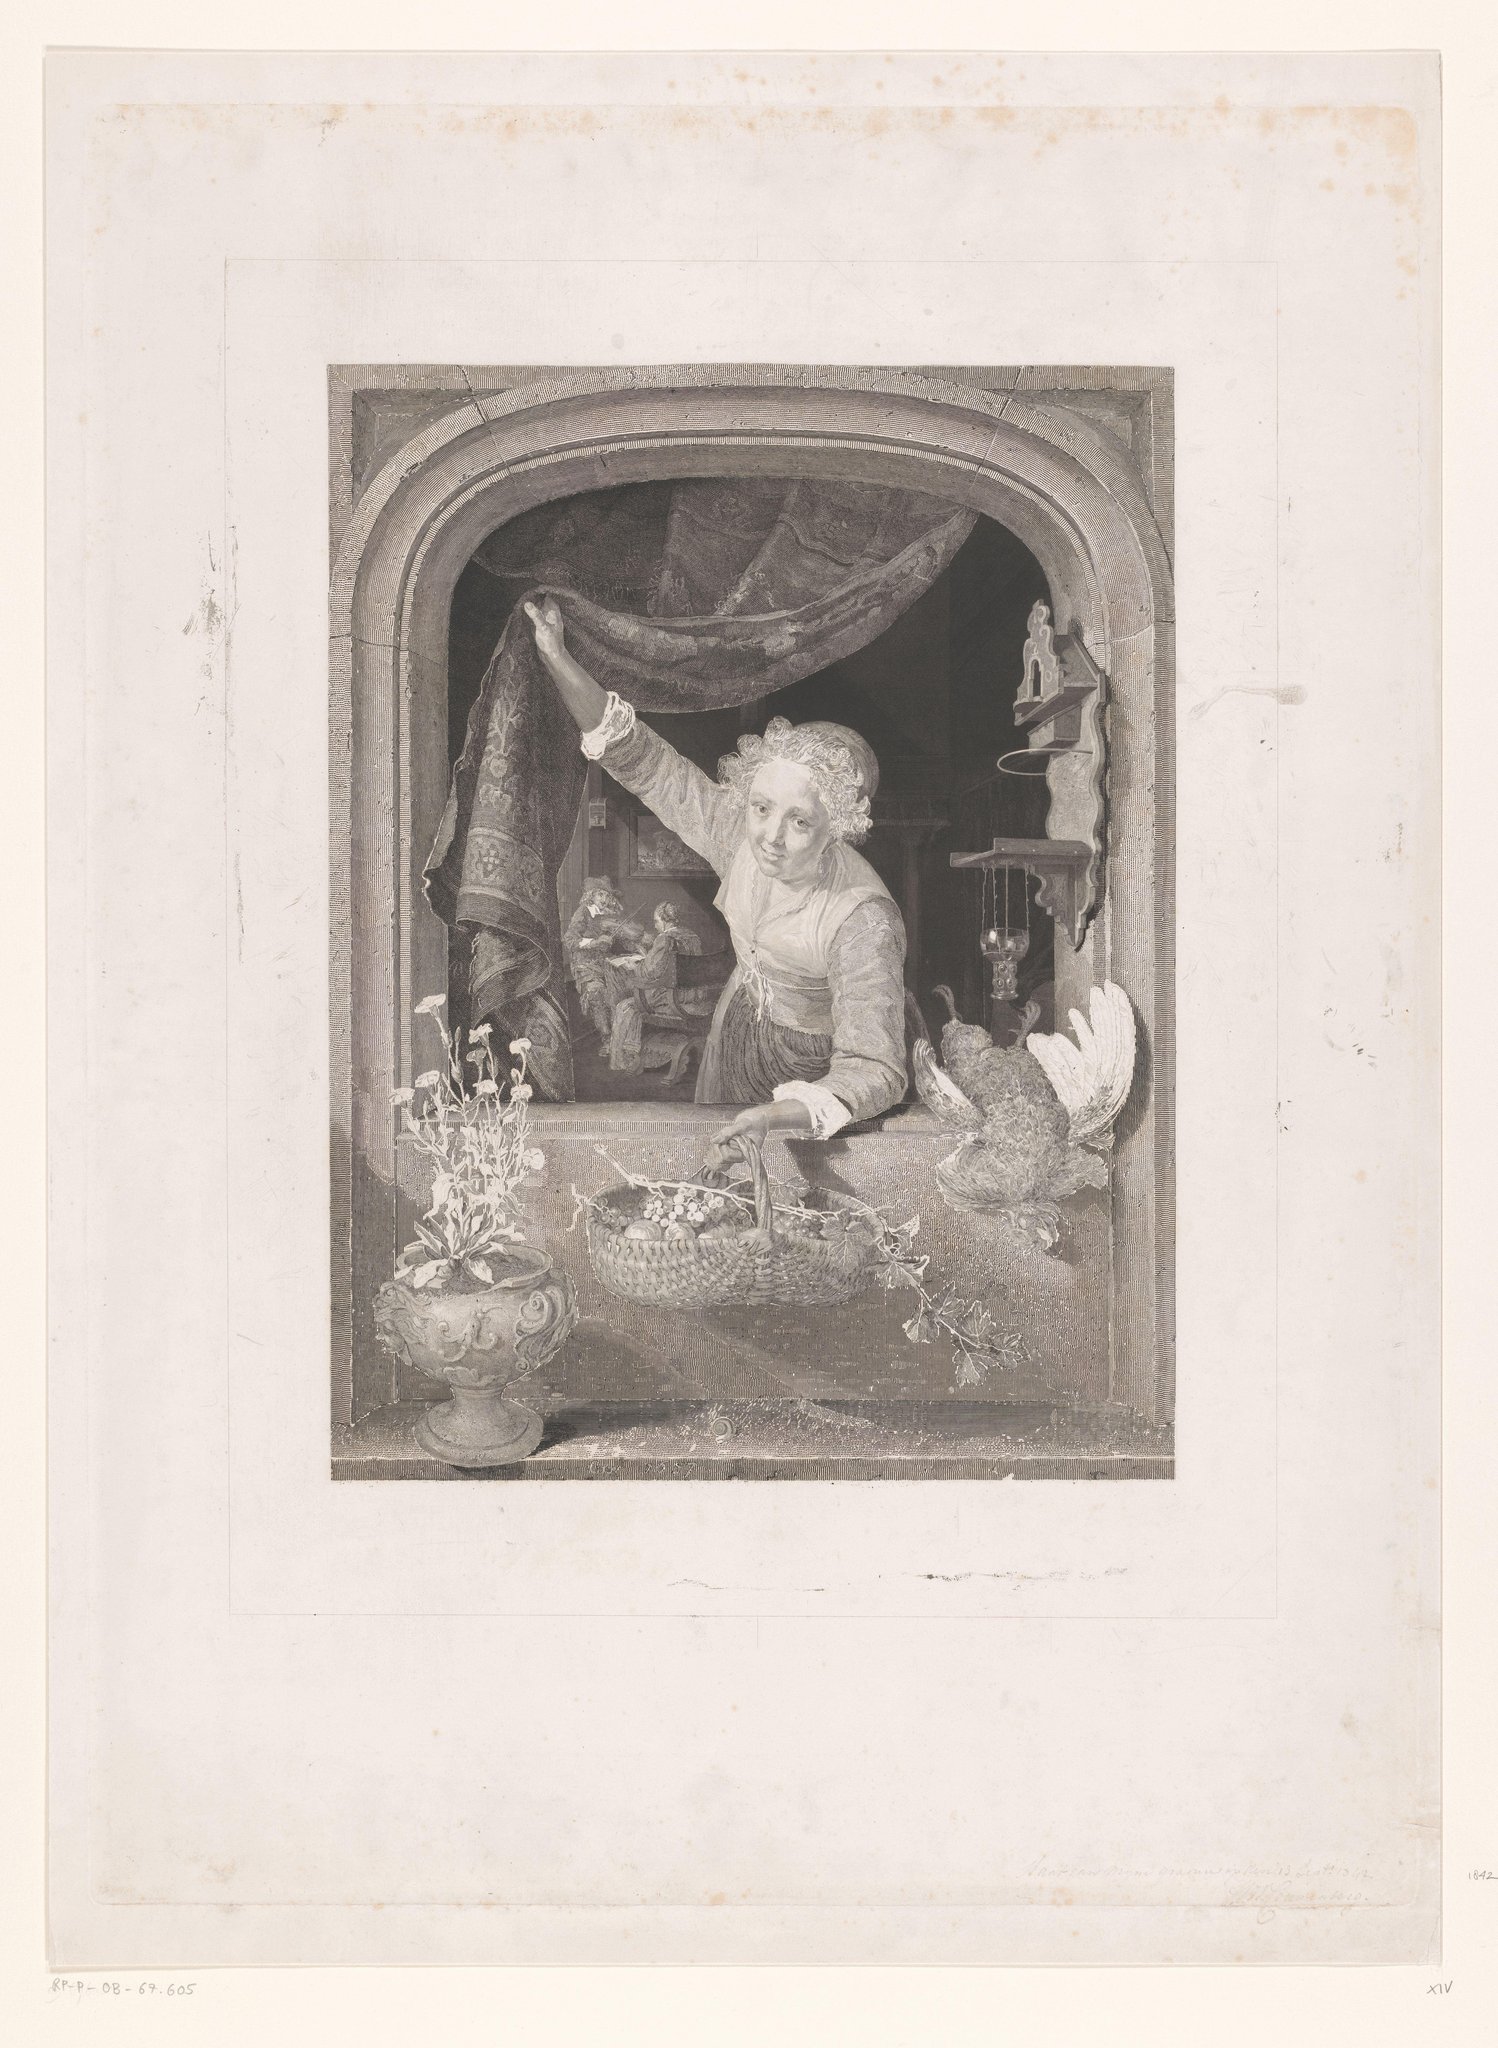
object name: print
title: Vrouw met mand met vruchten in de hand bij het raam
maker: henricus wilhelmus couwenberg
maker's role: draughtsman, print maker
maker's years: 1814-1845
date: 1842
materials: paper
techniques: etching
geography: amsterdam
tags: human figure at (open) window, seen from outside, shop-window, show-window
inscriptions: inscription: ‘Staat van mijne gravure op den 13 Sept. 1842. H.W. Couwenberg.’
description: Een jonge vrouw met een mand met vruchten in de hand hangt uit een venster. Ze houdt het gordijn opzij zodat het interieur achter haar zichtbaar is. In het vertrek zijn een man en een vrouw aan het musiceren. In de vensterbank hangt een vogelhuis, ligt een dode haan en staat een vaas met bloemen.